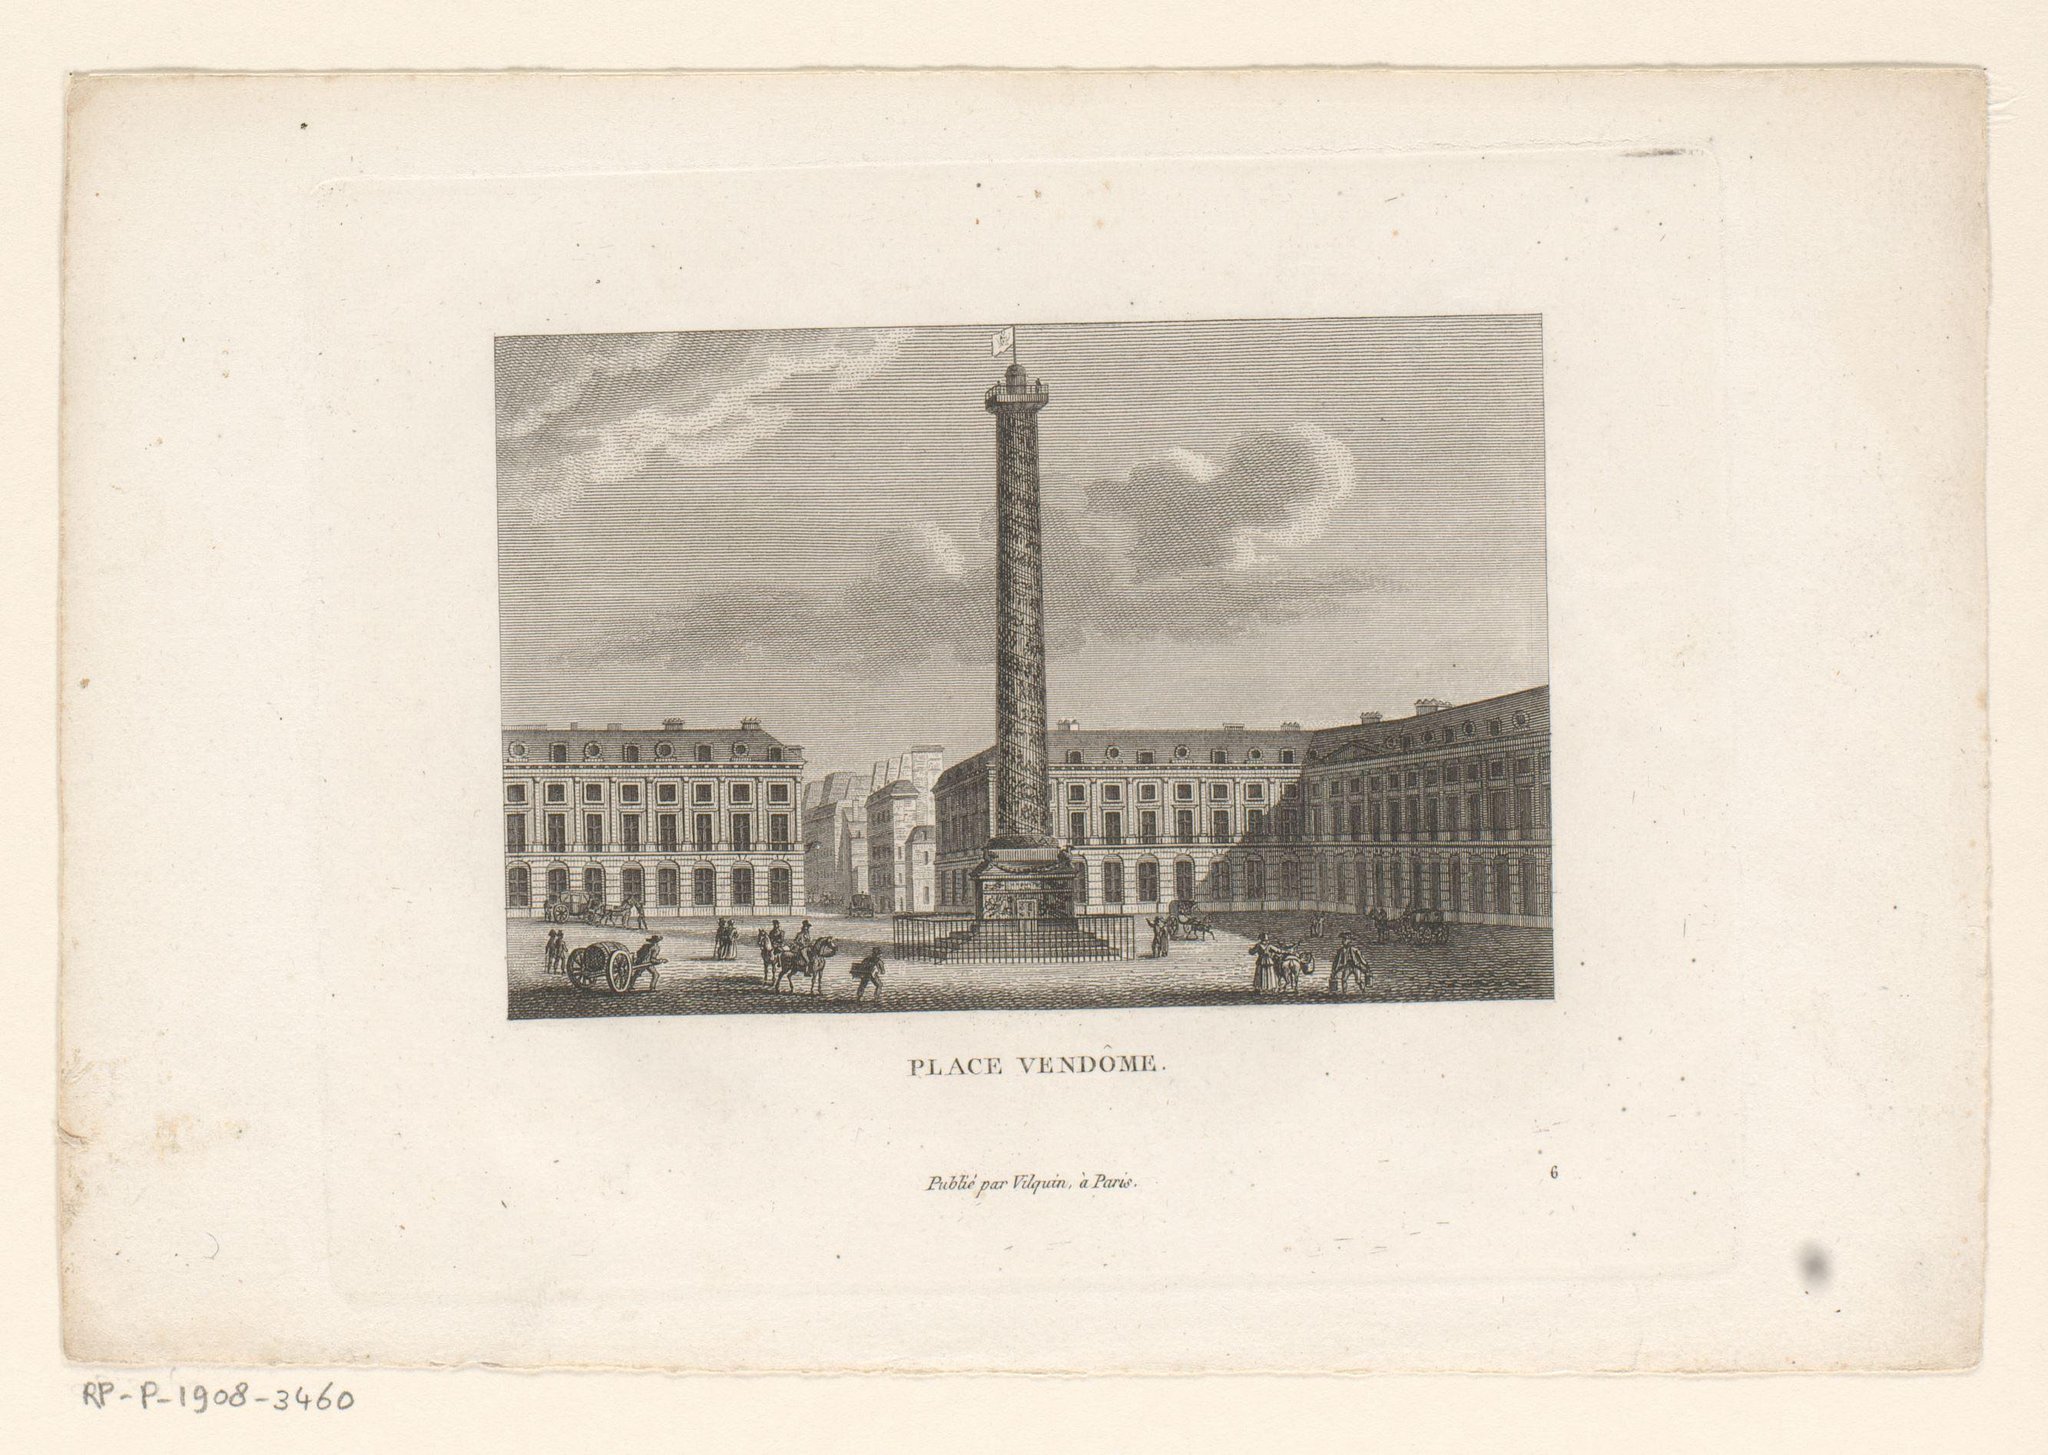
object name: print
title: Gezicht op het Place Vendôme te Parijs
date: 1818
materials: paper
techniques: etching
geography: paris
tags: square, place, circus, etc., city-view in general; 'veduta', triumphal column with helical friezes, paris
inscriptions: collector's mark: Lugt 2228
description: Maakt deel uit van een serie met 60 platen van monumenten, kathedralen en paleizen in Parijs.